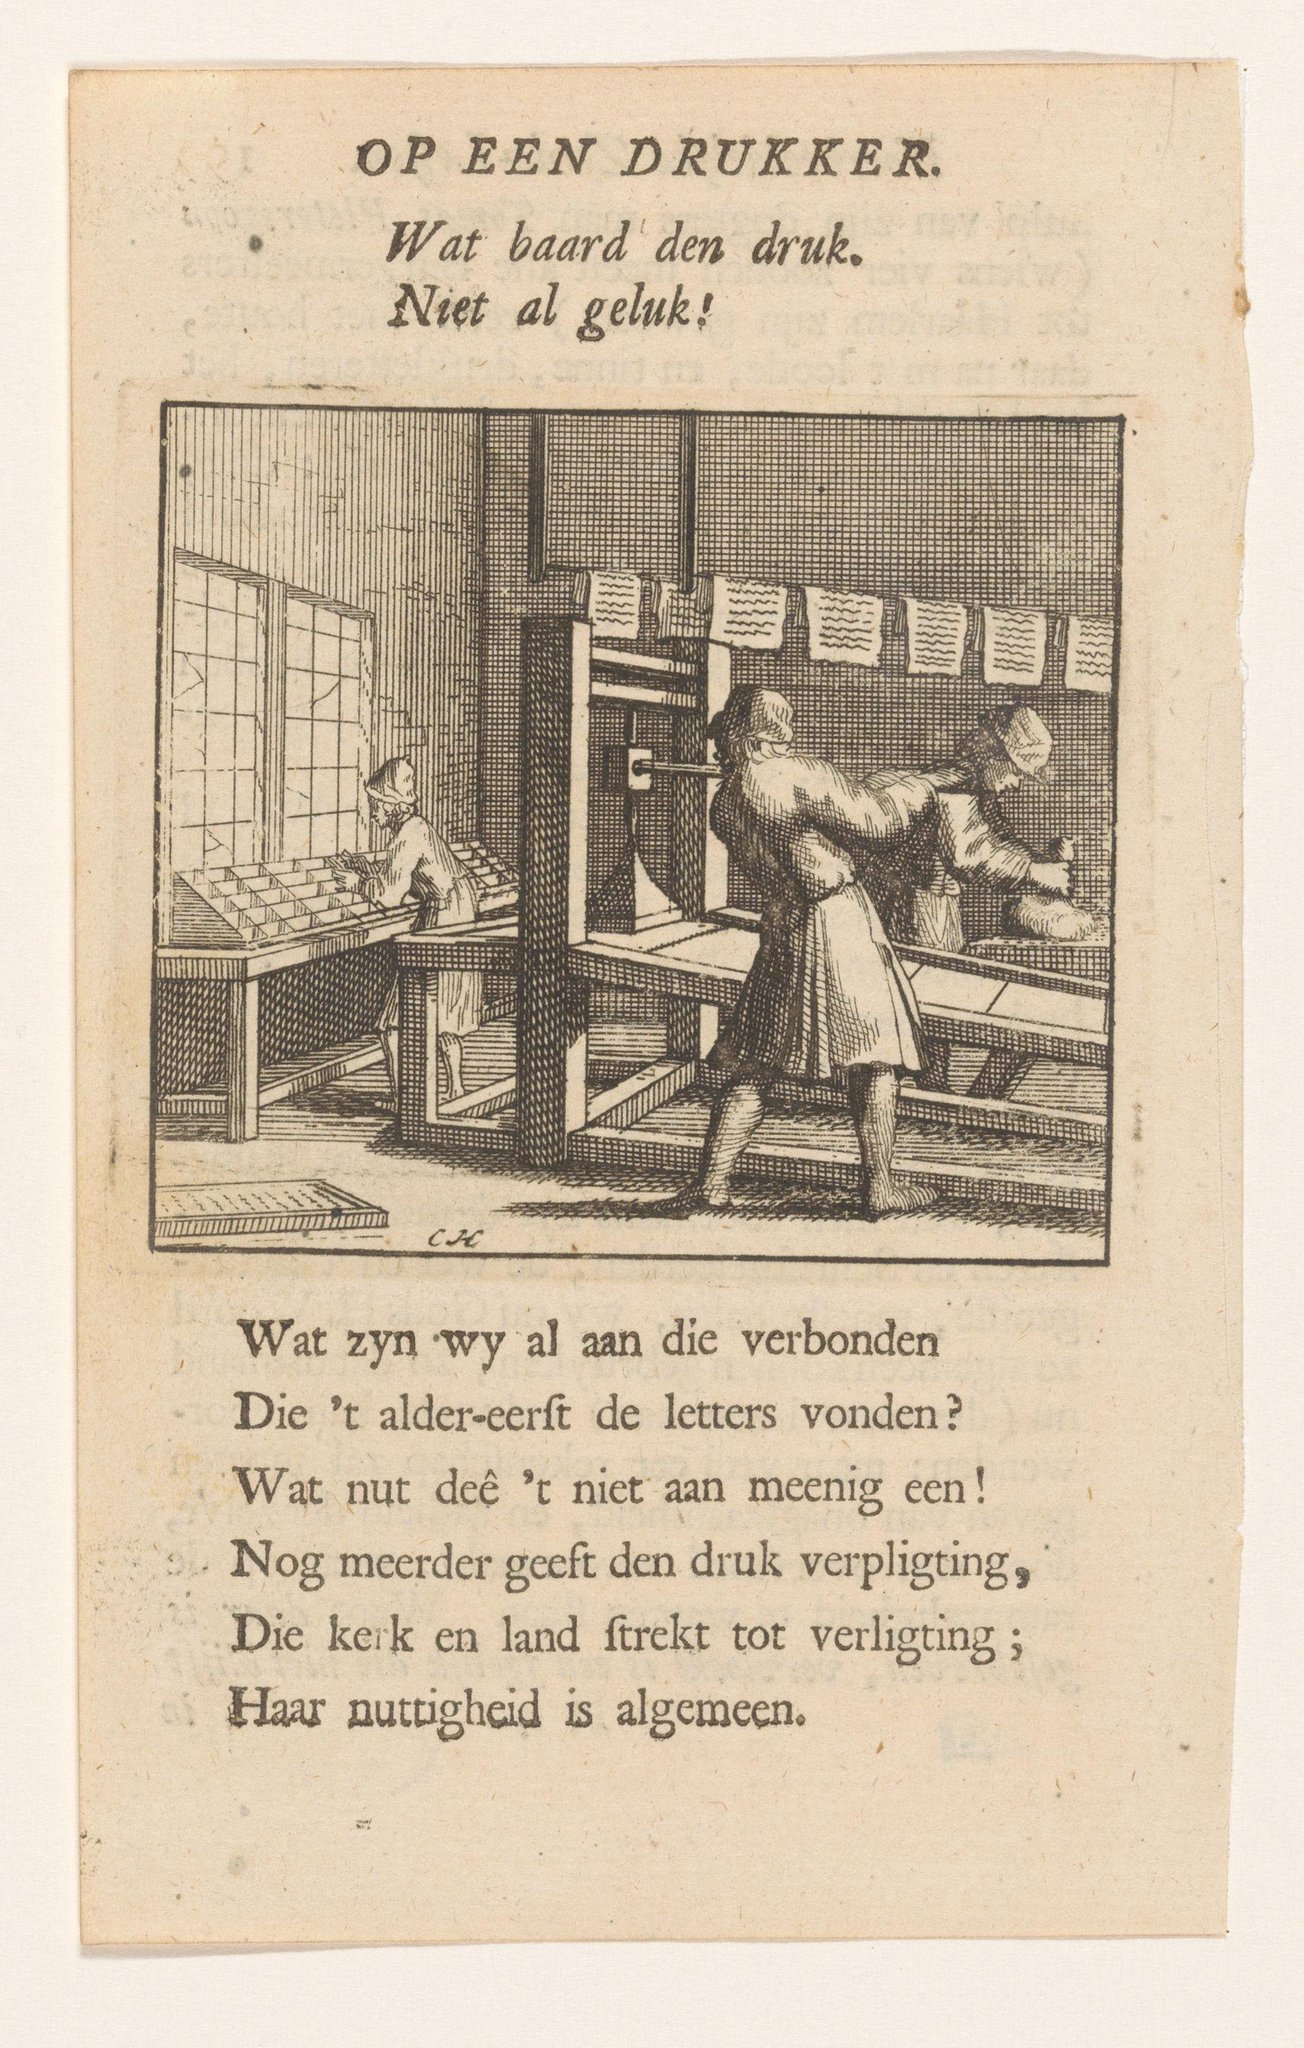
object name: print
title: Werkplaats van een boekdrukker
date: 1709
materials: paper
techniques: etching, letterpress printing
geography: amsterdam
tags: printing press, tools, implements of printer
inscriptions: collector's mark: Lugt 2228, collector's mark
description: Prent voor het eerst gebruikt in: Graauwhart, Hendrik. Voorbeeldlyke Zeede-lessen. Amsterdam: Johannes Ratelband, 1709. Deze prent is afkomstig uit een latere editie, waarbij de gegraveerde tekst onder de afbeelding is vervangen door tekst in boekdruk.